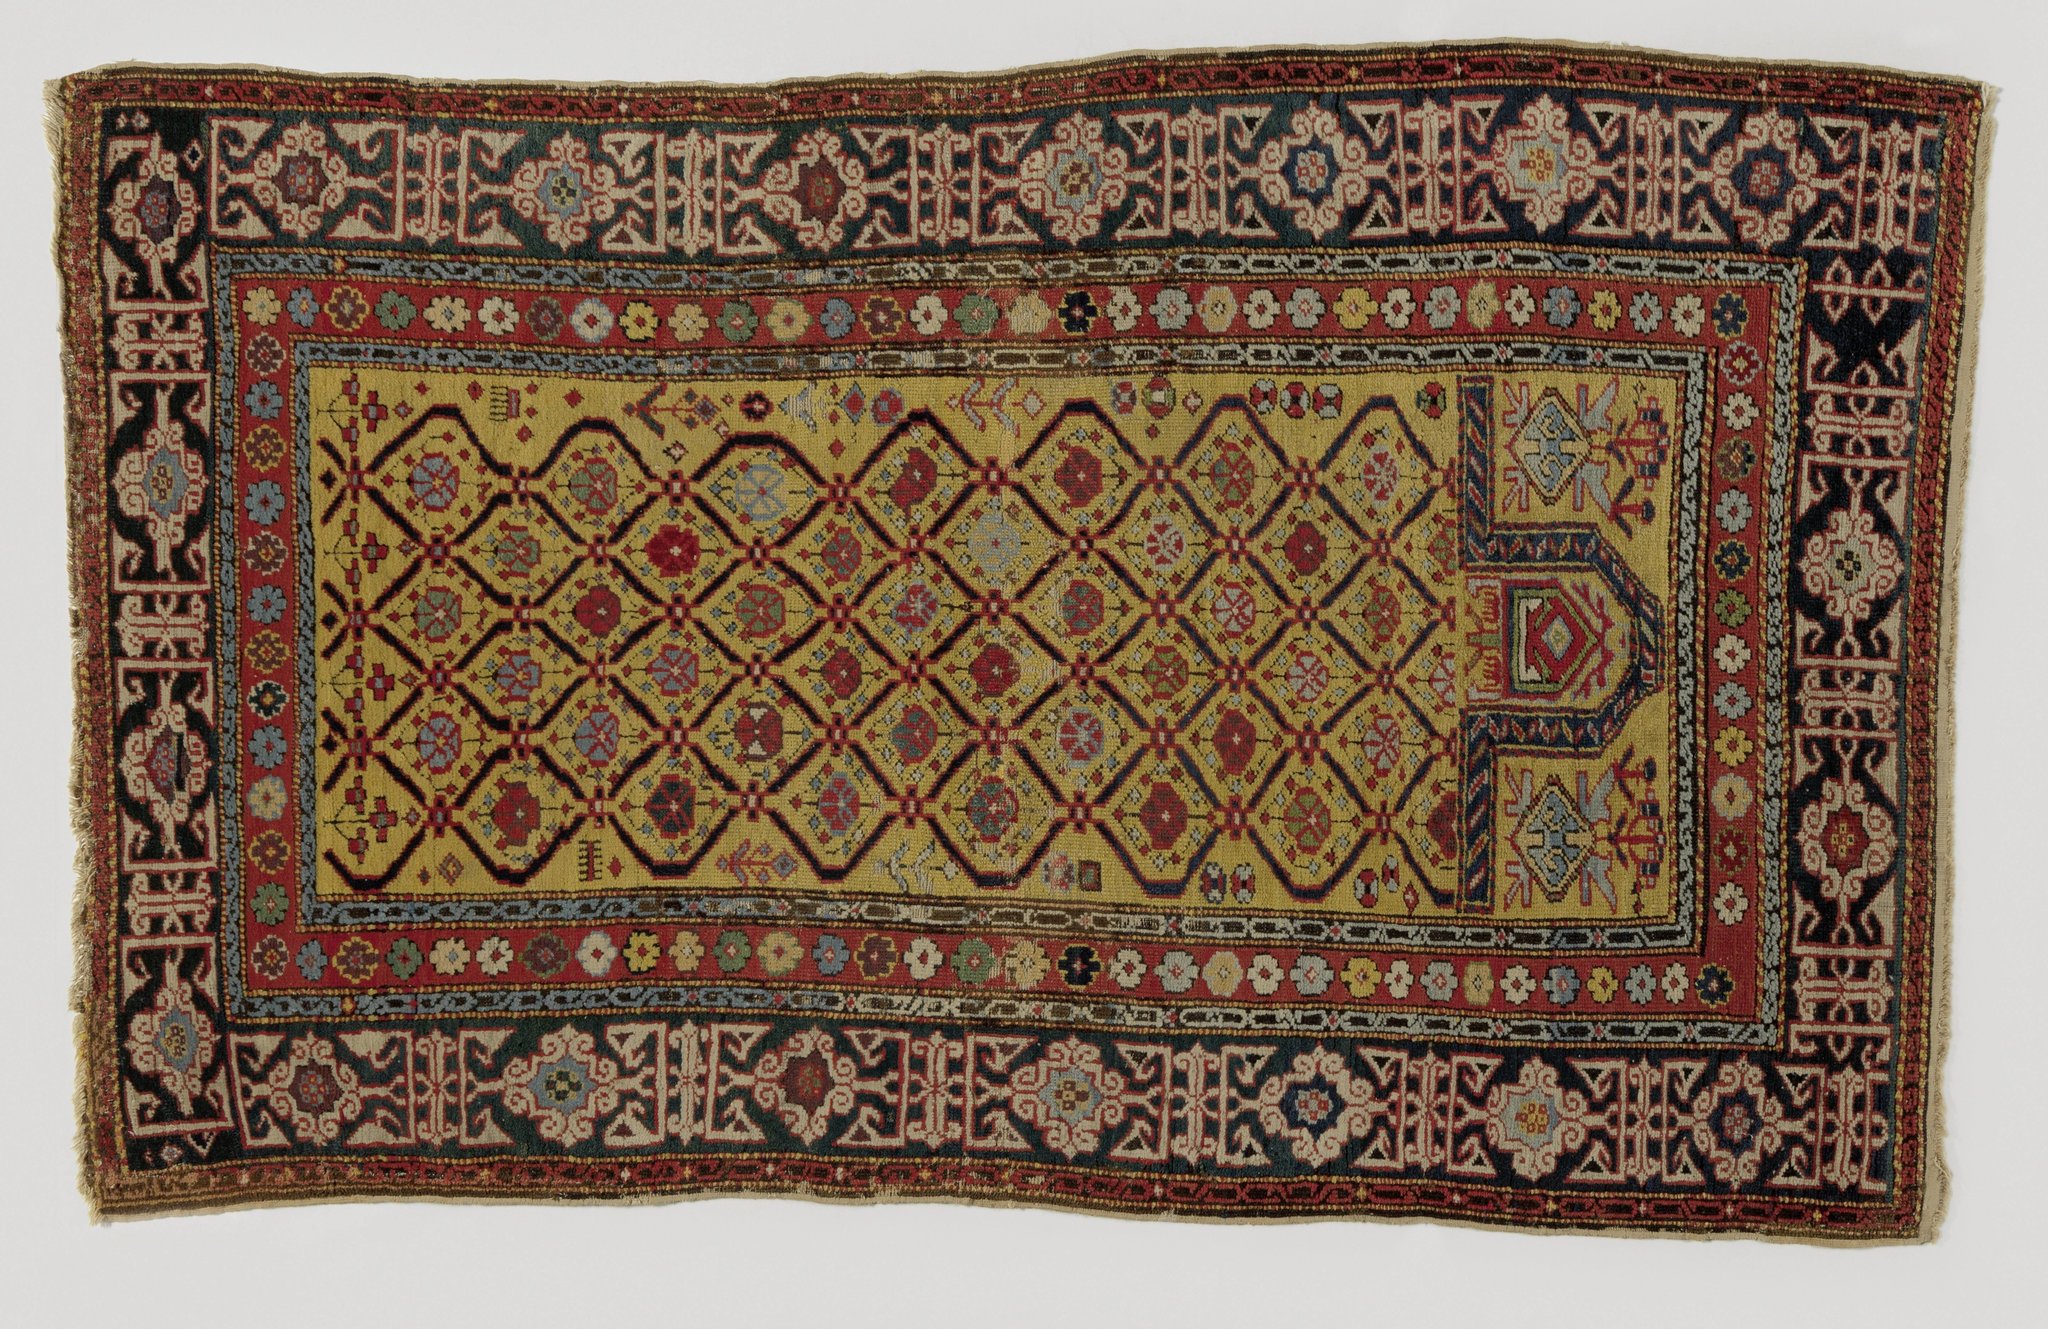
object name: oriental rug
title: Oosters tapijt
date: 1830-1870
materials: wool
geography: shirvan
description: Oosters tapijt, bidkleed. In het middenveld een goudgele mihrab met een bruinzwart rasterpatroon en bloemen. In de top van de nis een amuletachtig ornament. Vijfvoudige rand waarvan de breedste met een kufisch patroon.